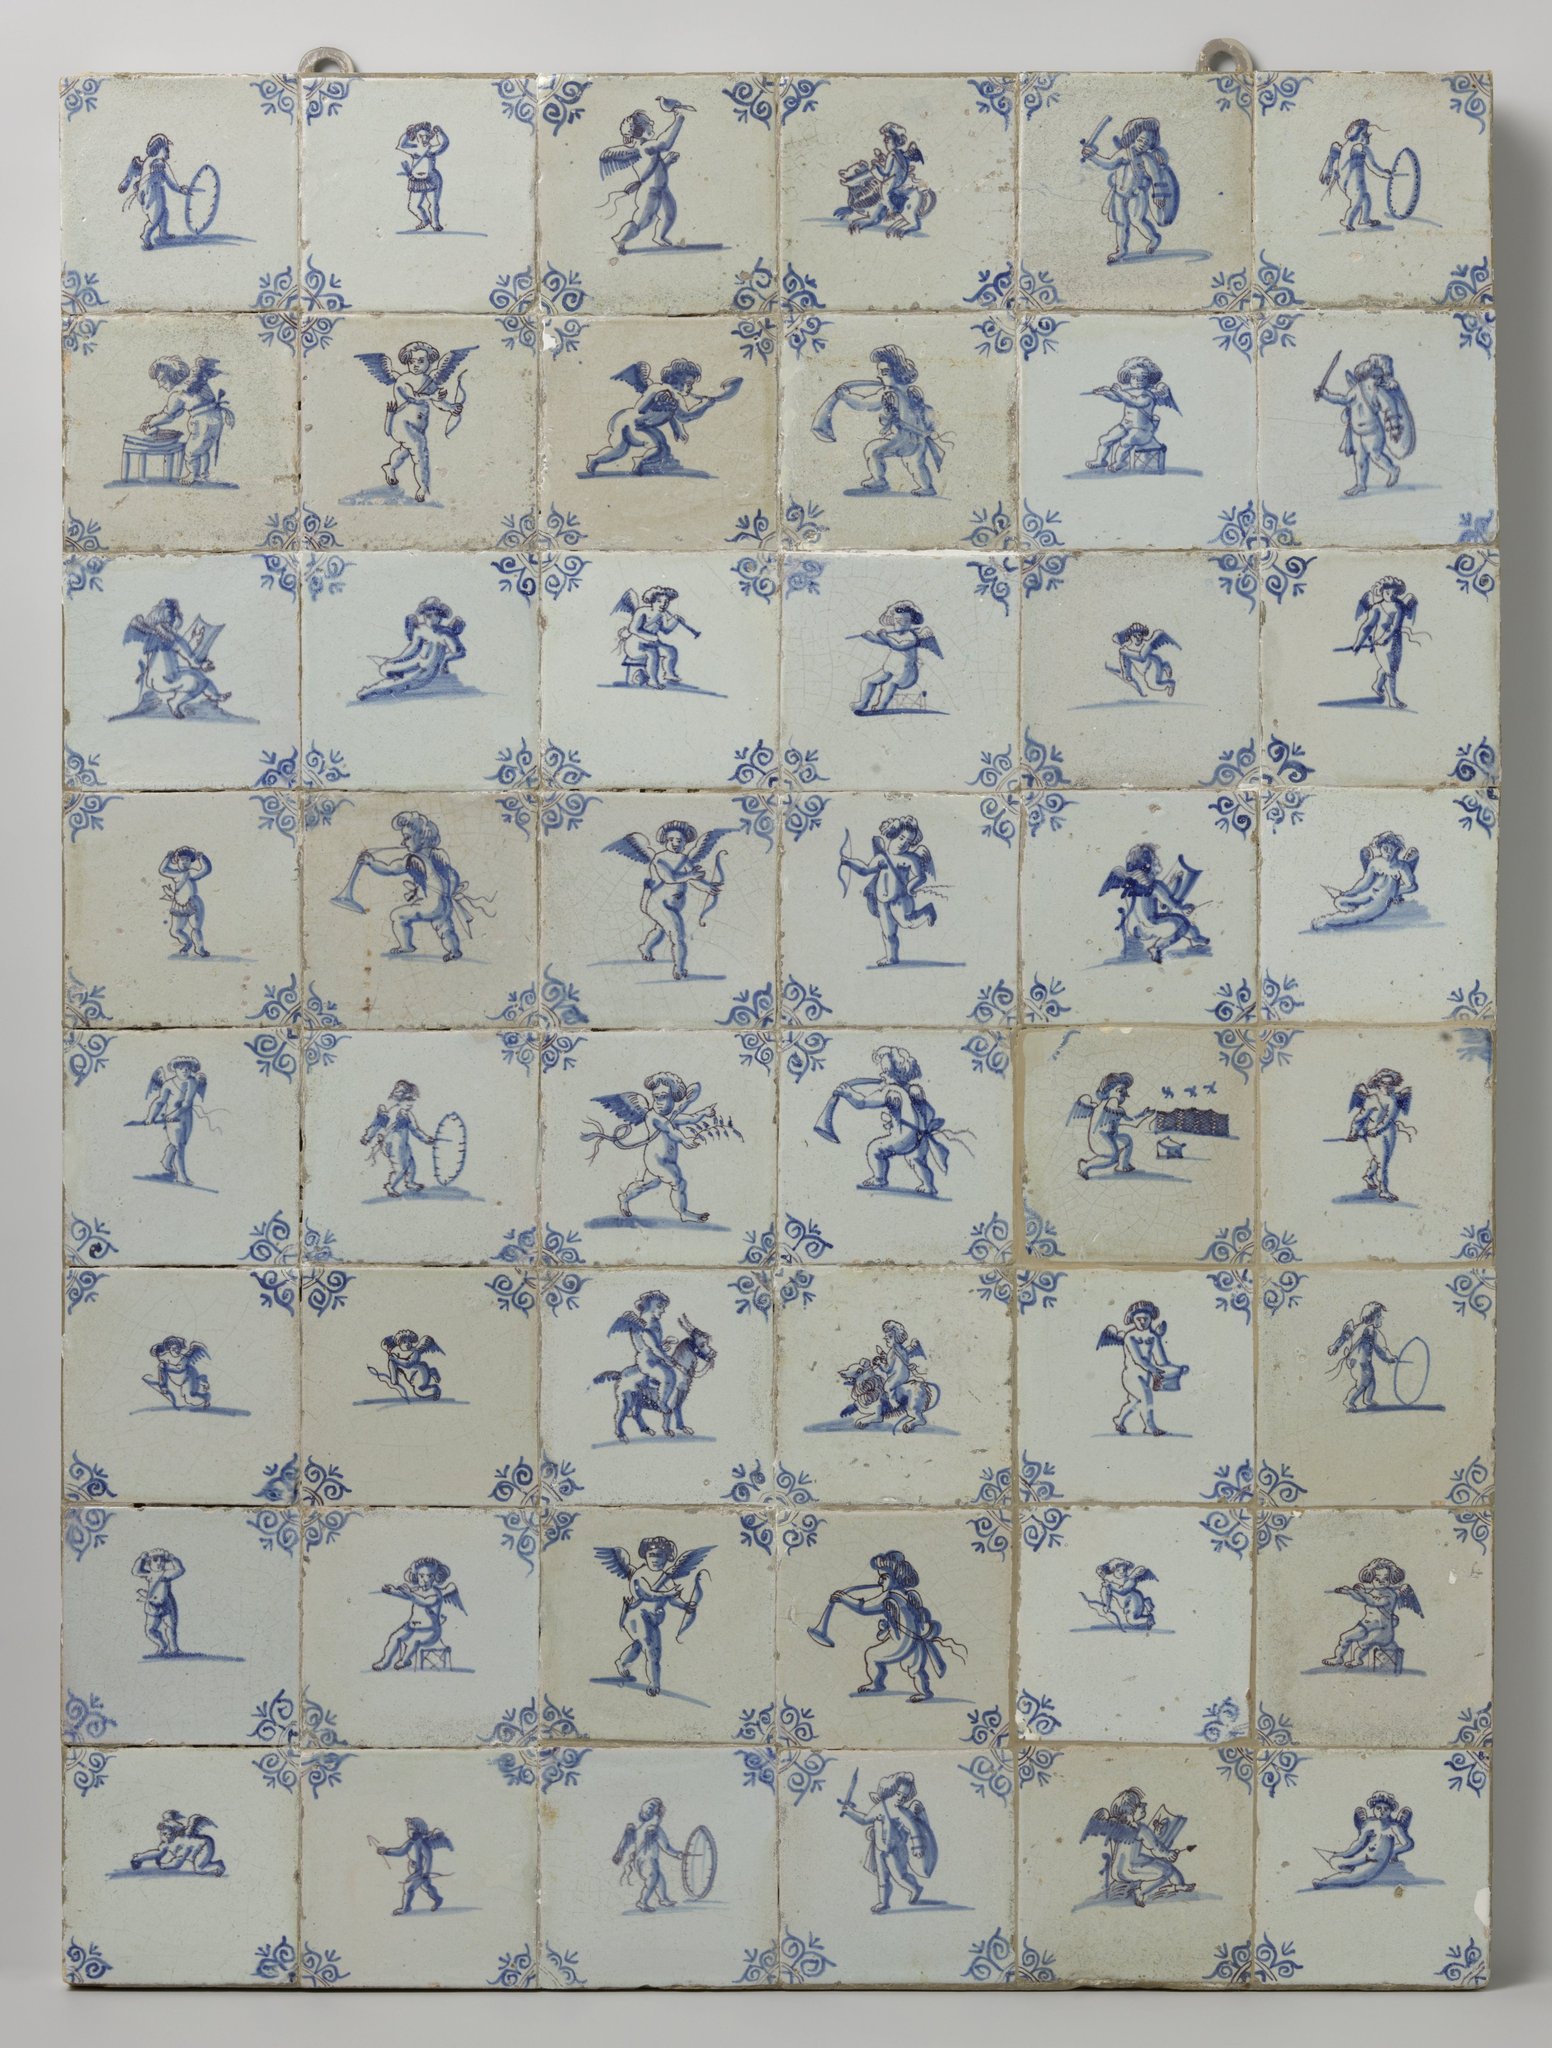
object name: tegelveld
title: Veld van achtenveertig tegels met Cupido's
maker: Anonymous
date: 1630-1670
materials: earthenware, glaze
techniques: maiolica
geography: netherlands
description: Veld van achtenveertig tegels (8 x 6) elk met een blauw en paars geschilderde Cupido en in de hoeken een ossenkop.